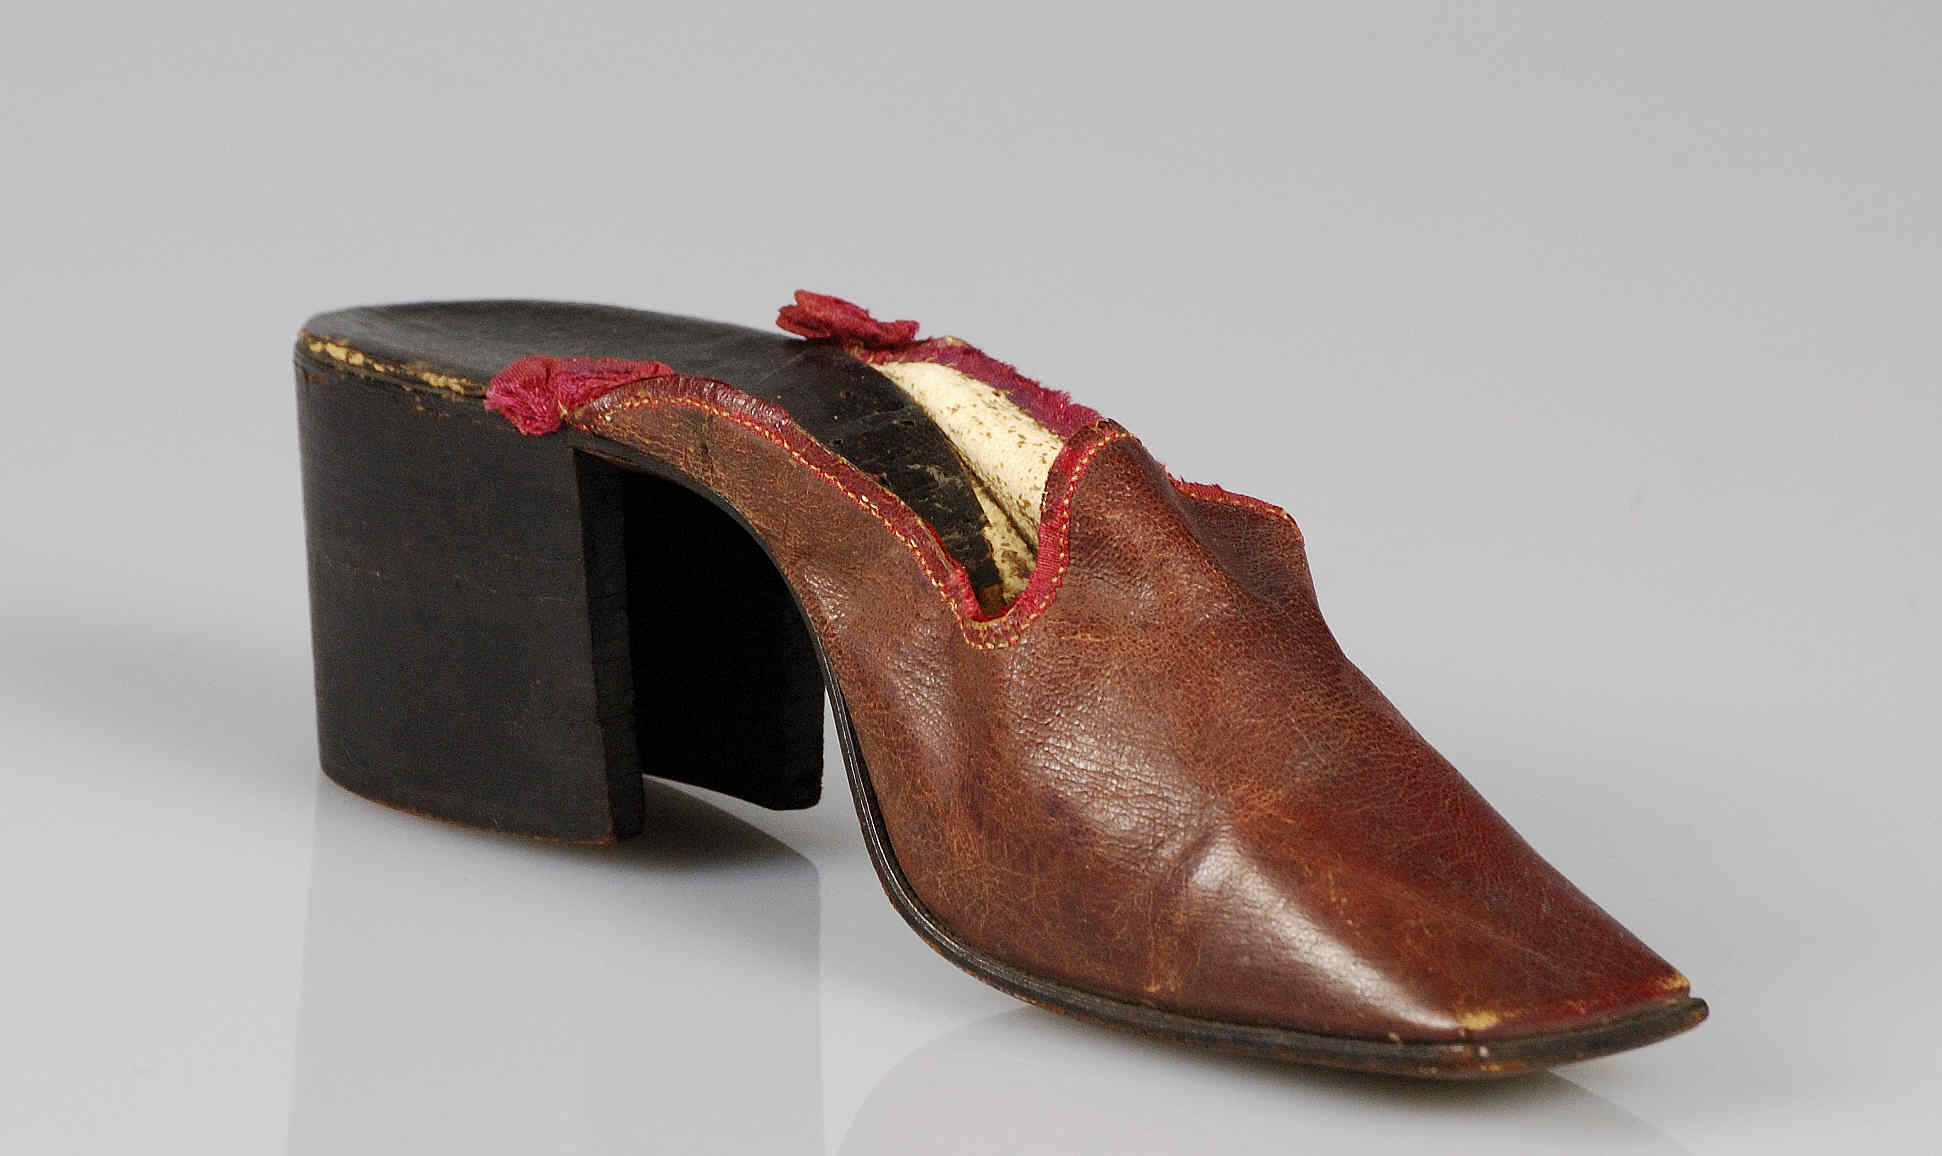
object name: mule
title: Mules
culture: middle eastern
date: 1801-1900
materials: leather